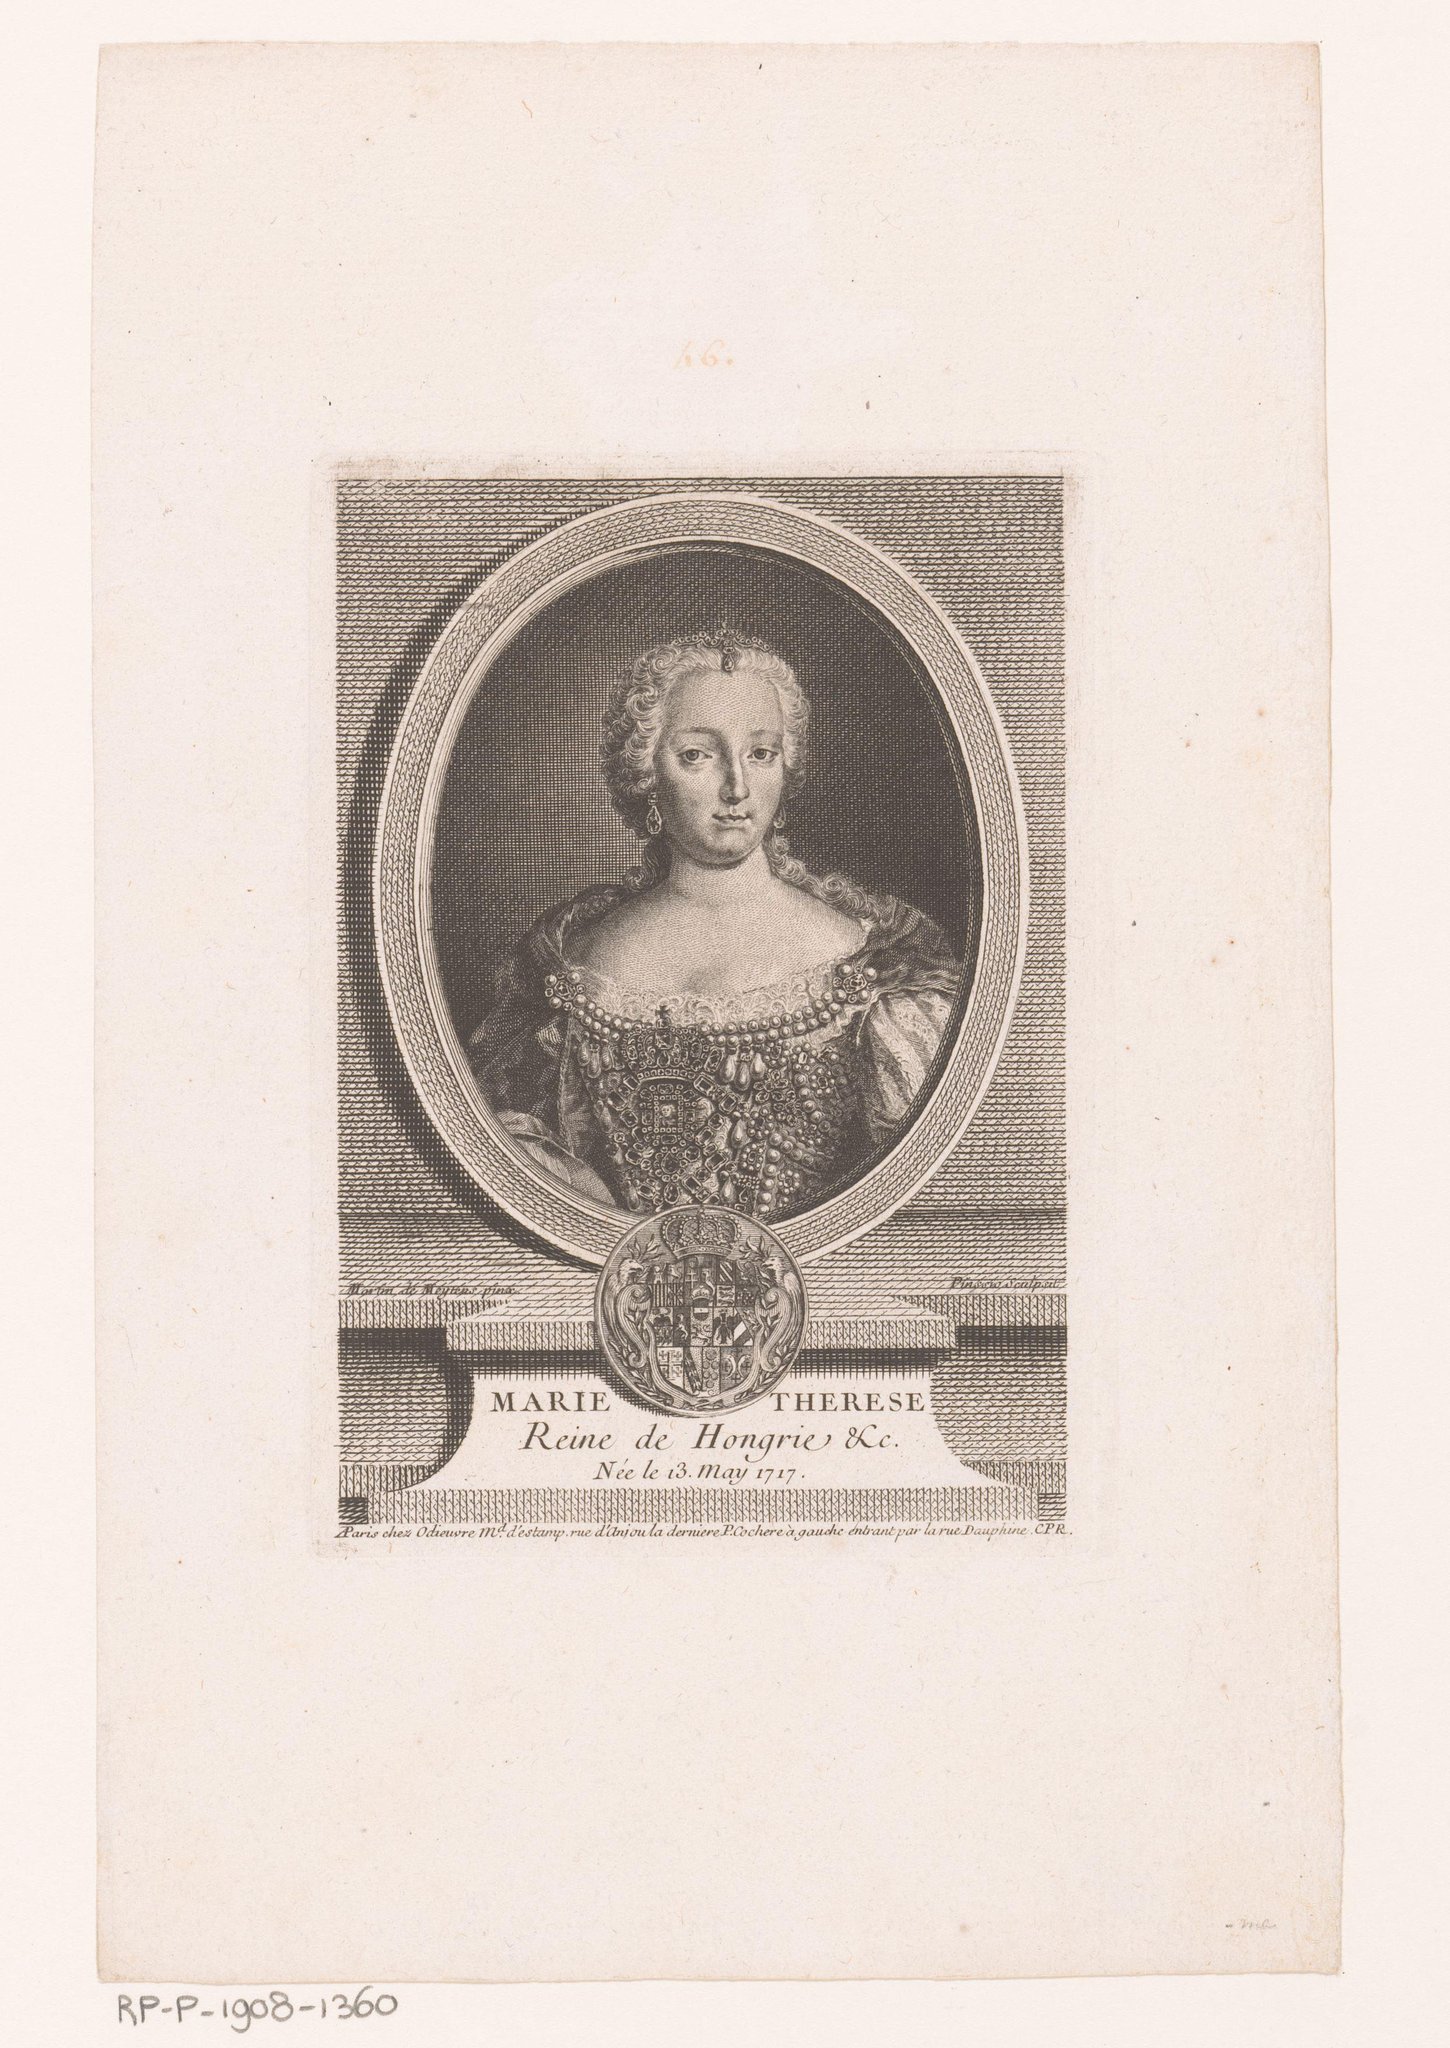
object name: book illustration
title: Marie Therese Reine de Hongrie &c.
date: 1755-1765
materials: paper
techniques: engraving, etching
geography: france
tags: maria theresia (rooms-duits keizerin), historical persons, emperor - bb - female ruler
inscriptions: collector's mark: Lugt 2228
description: Prent uit: Dreux du Radier, Jean-François. L'Europe illustré, contenant l'histoire abregée des souverains, des princes, des prélats, des ministres, (...) en Europe: dans le XVe. siècle compris, jusqu'à présent. Parijs: Michel Odieuvre en André-François Le Breton, 1755-1765.